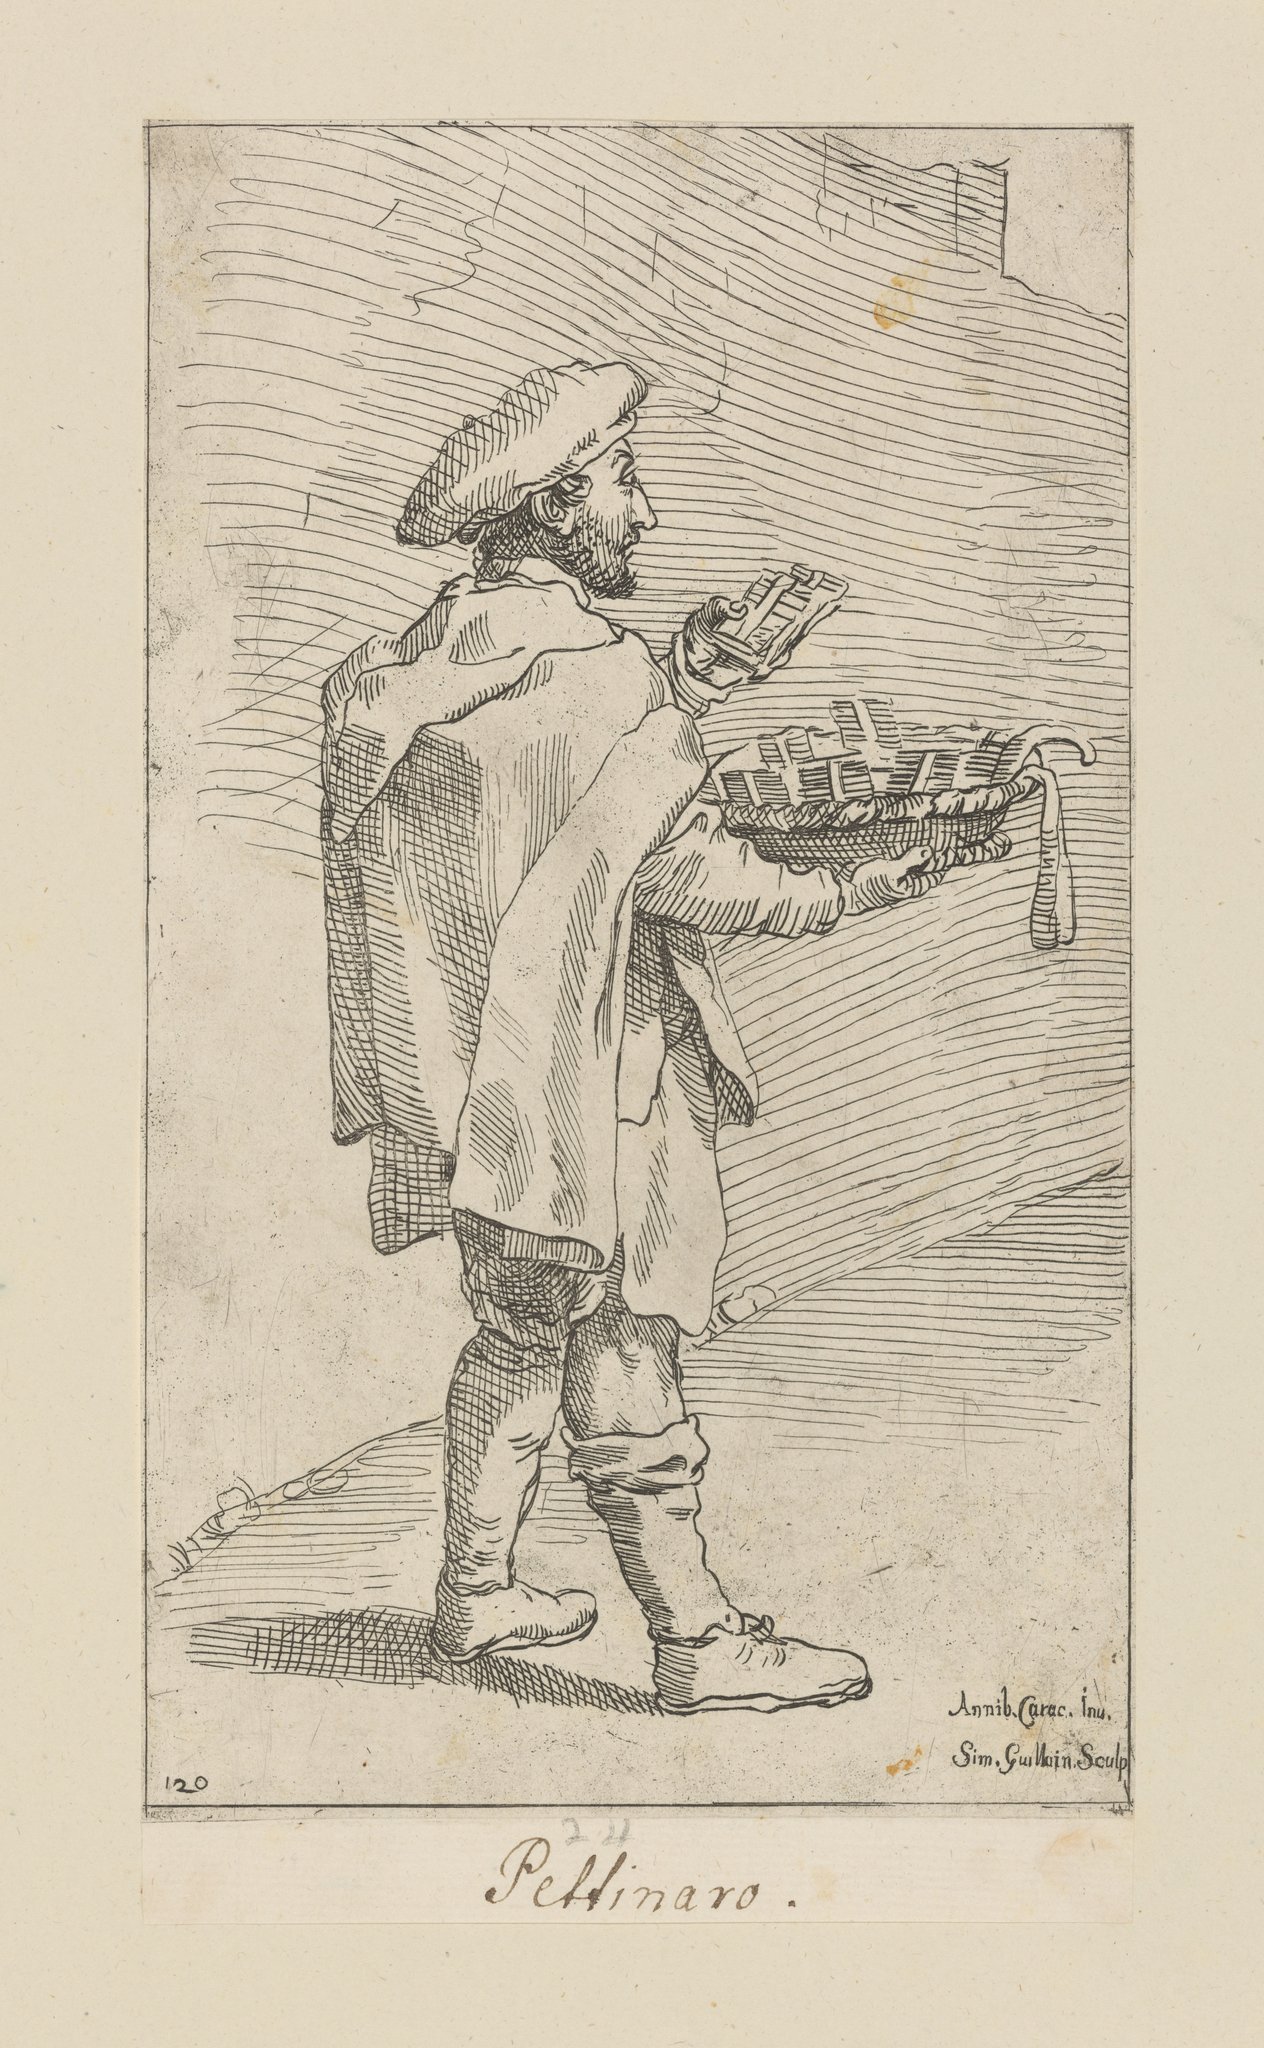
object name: print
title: Plate 20: Wool carder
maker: simon guillain ii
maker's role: artist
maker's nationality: french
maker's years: 1618-1718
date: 1646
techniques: etching